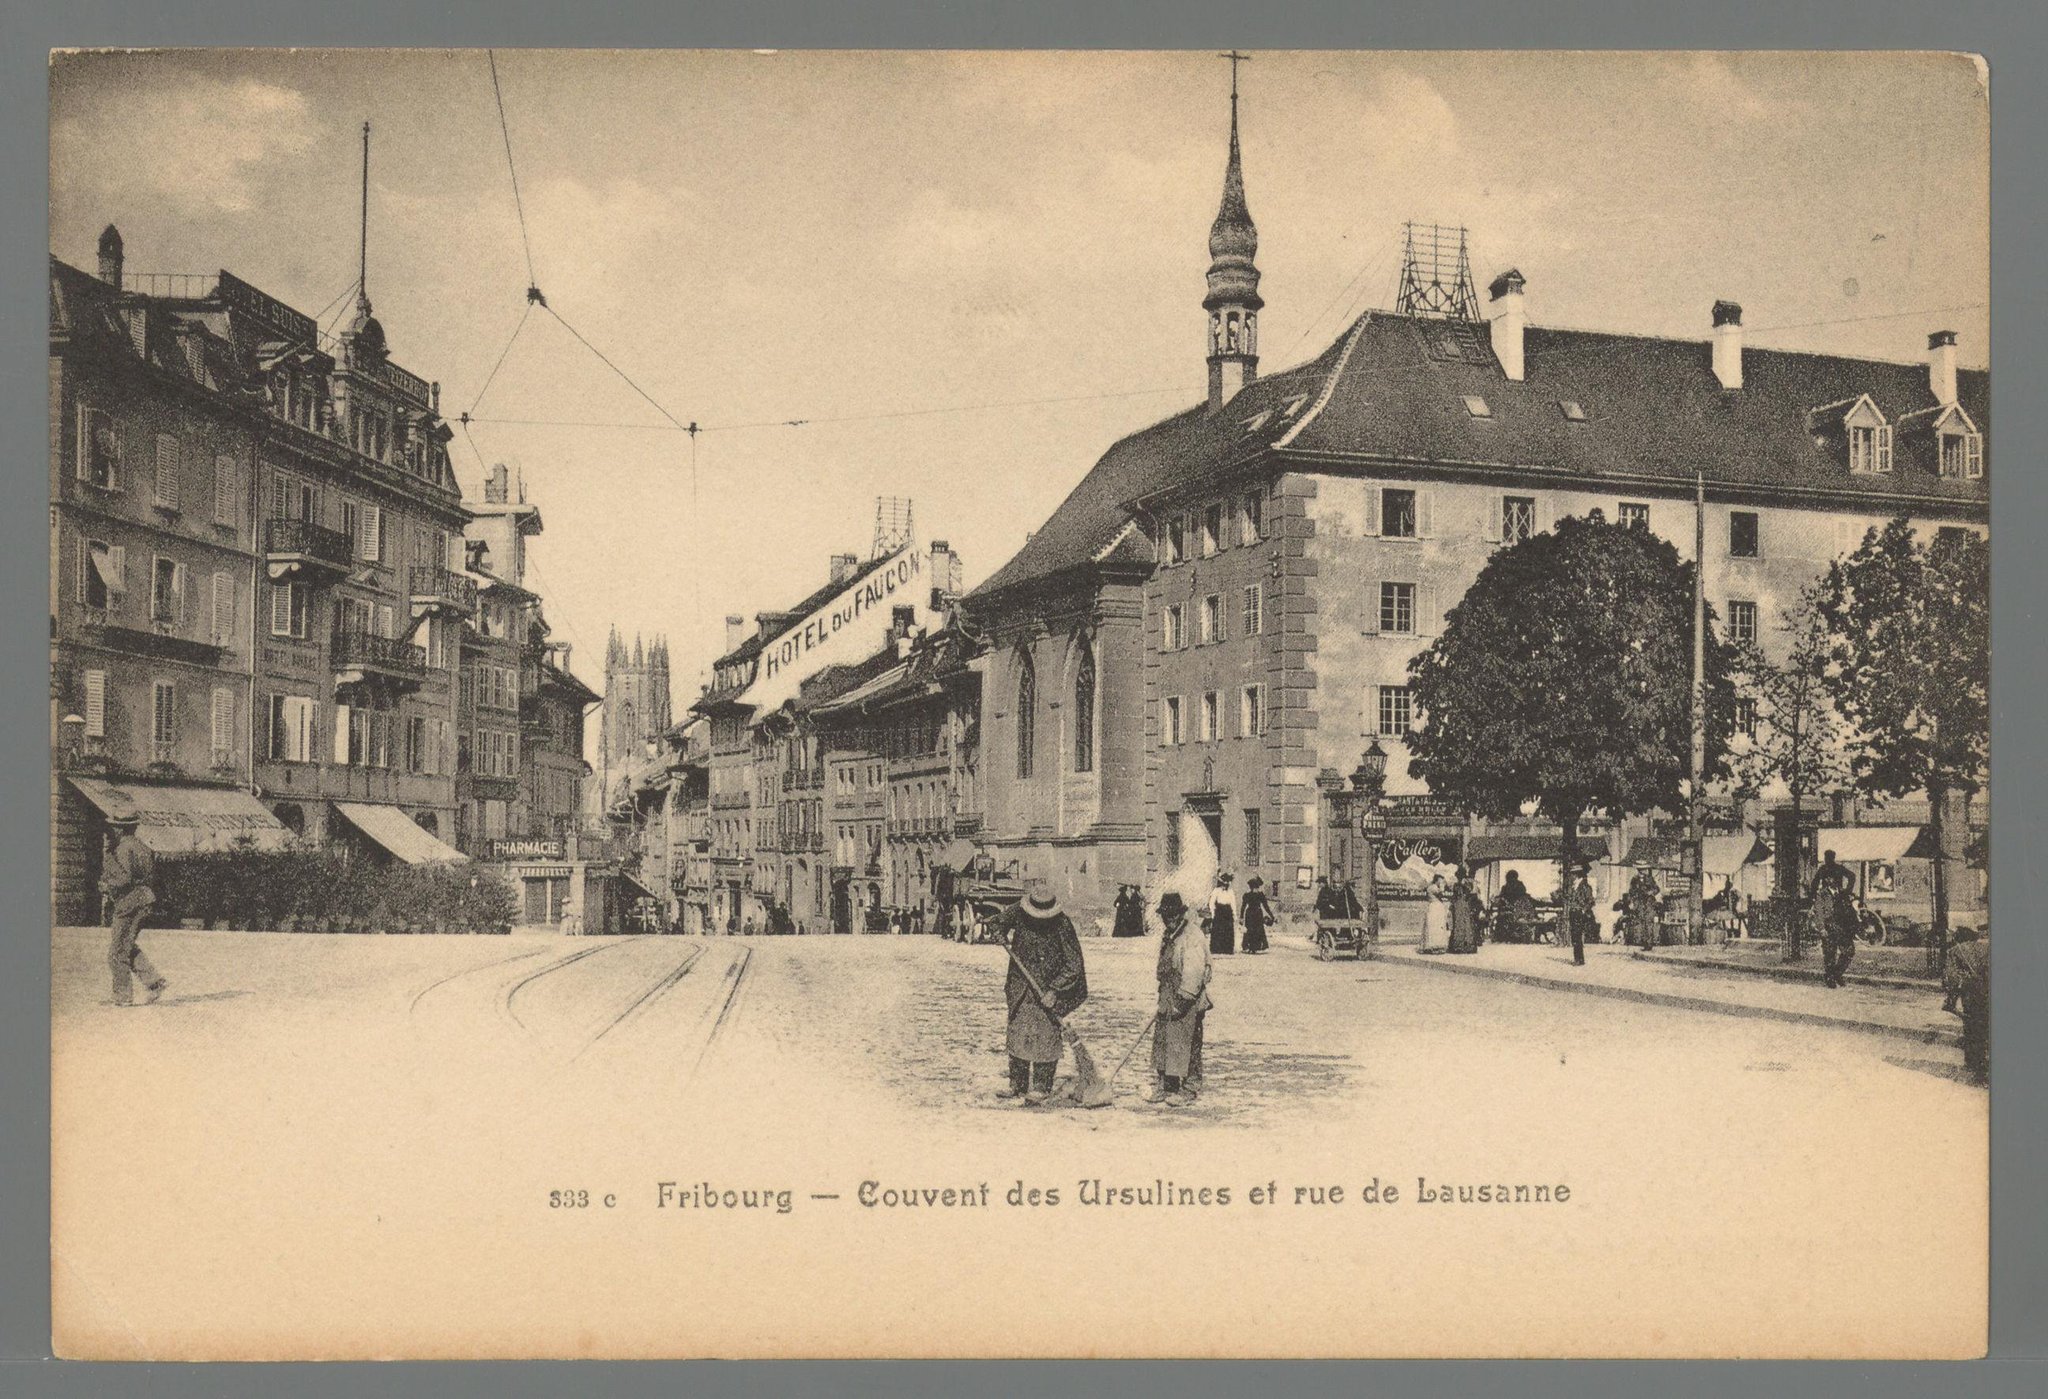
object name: photomechanical print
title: Fribourg. Couvent des Ursulines et Rue de Lausanne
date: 1903-1905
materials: cardboard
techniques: photograph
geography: neuchatel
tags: tramway, tram, street (+ city(-scape) with figures, staffage)